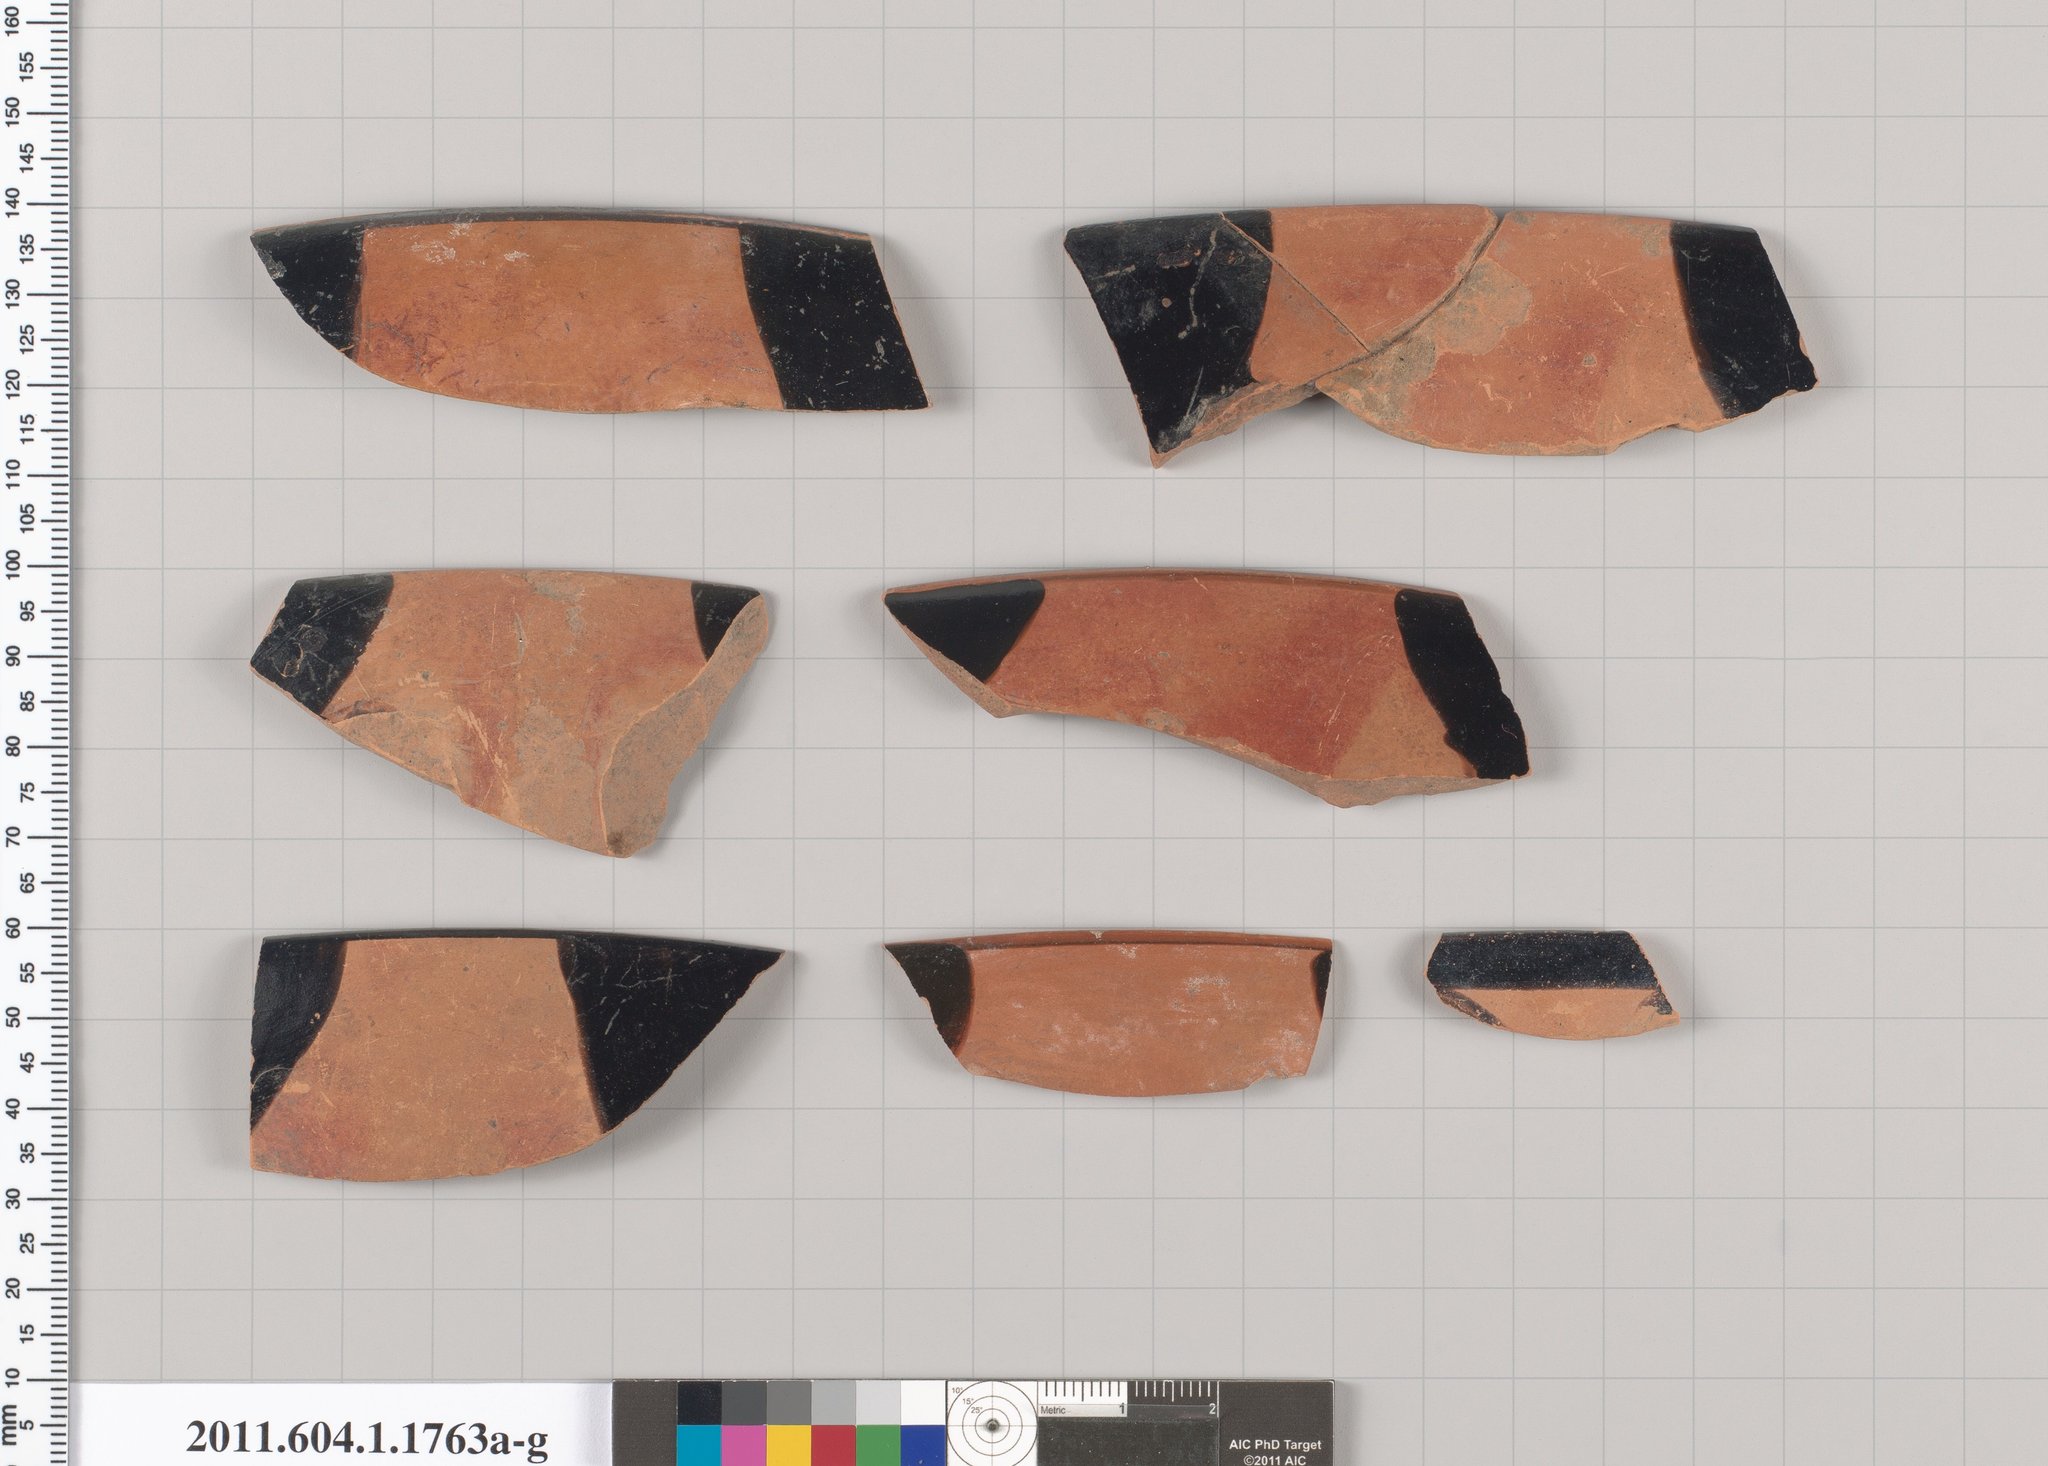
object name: kylix fragment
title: Terracotta rim fragments of kylikes(drinking cups)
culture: greek, attic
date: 500-401 BCE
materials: terracotta